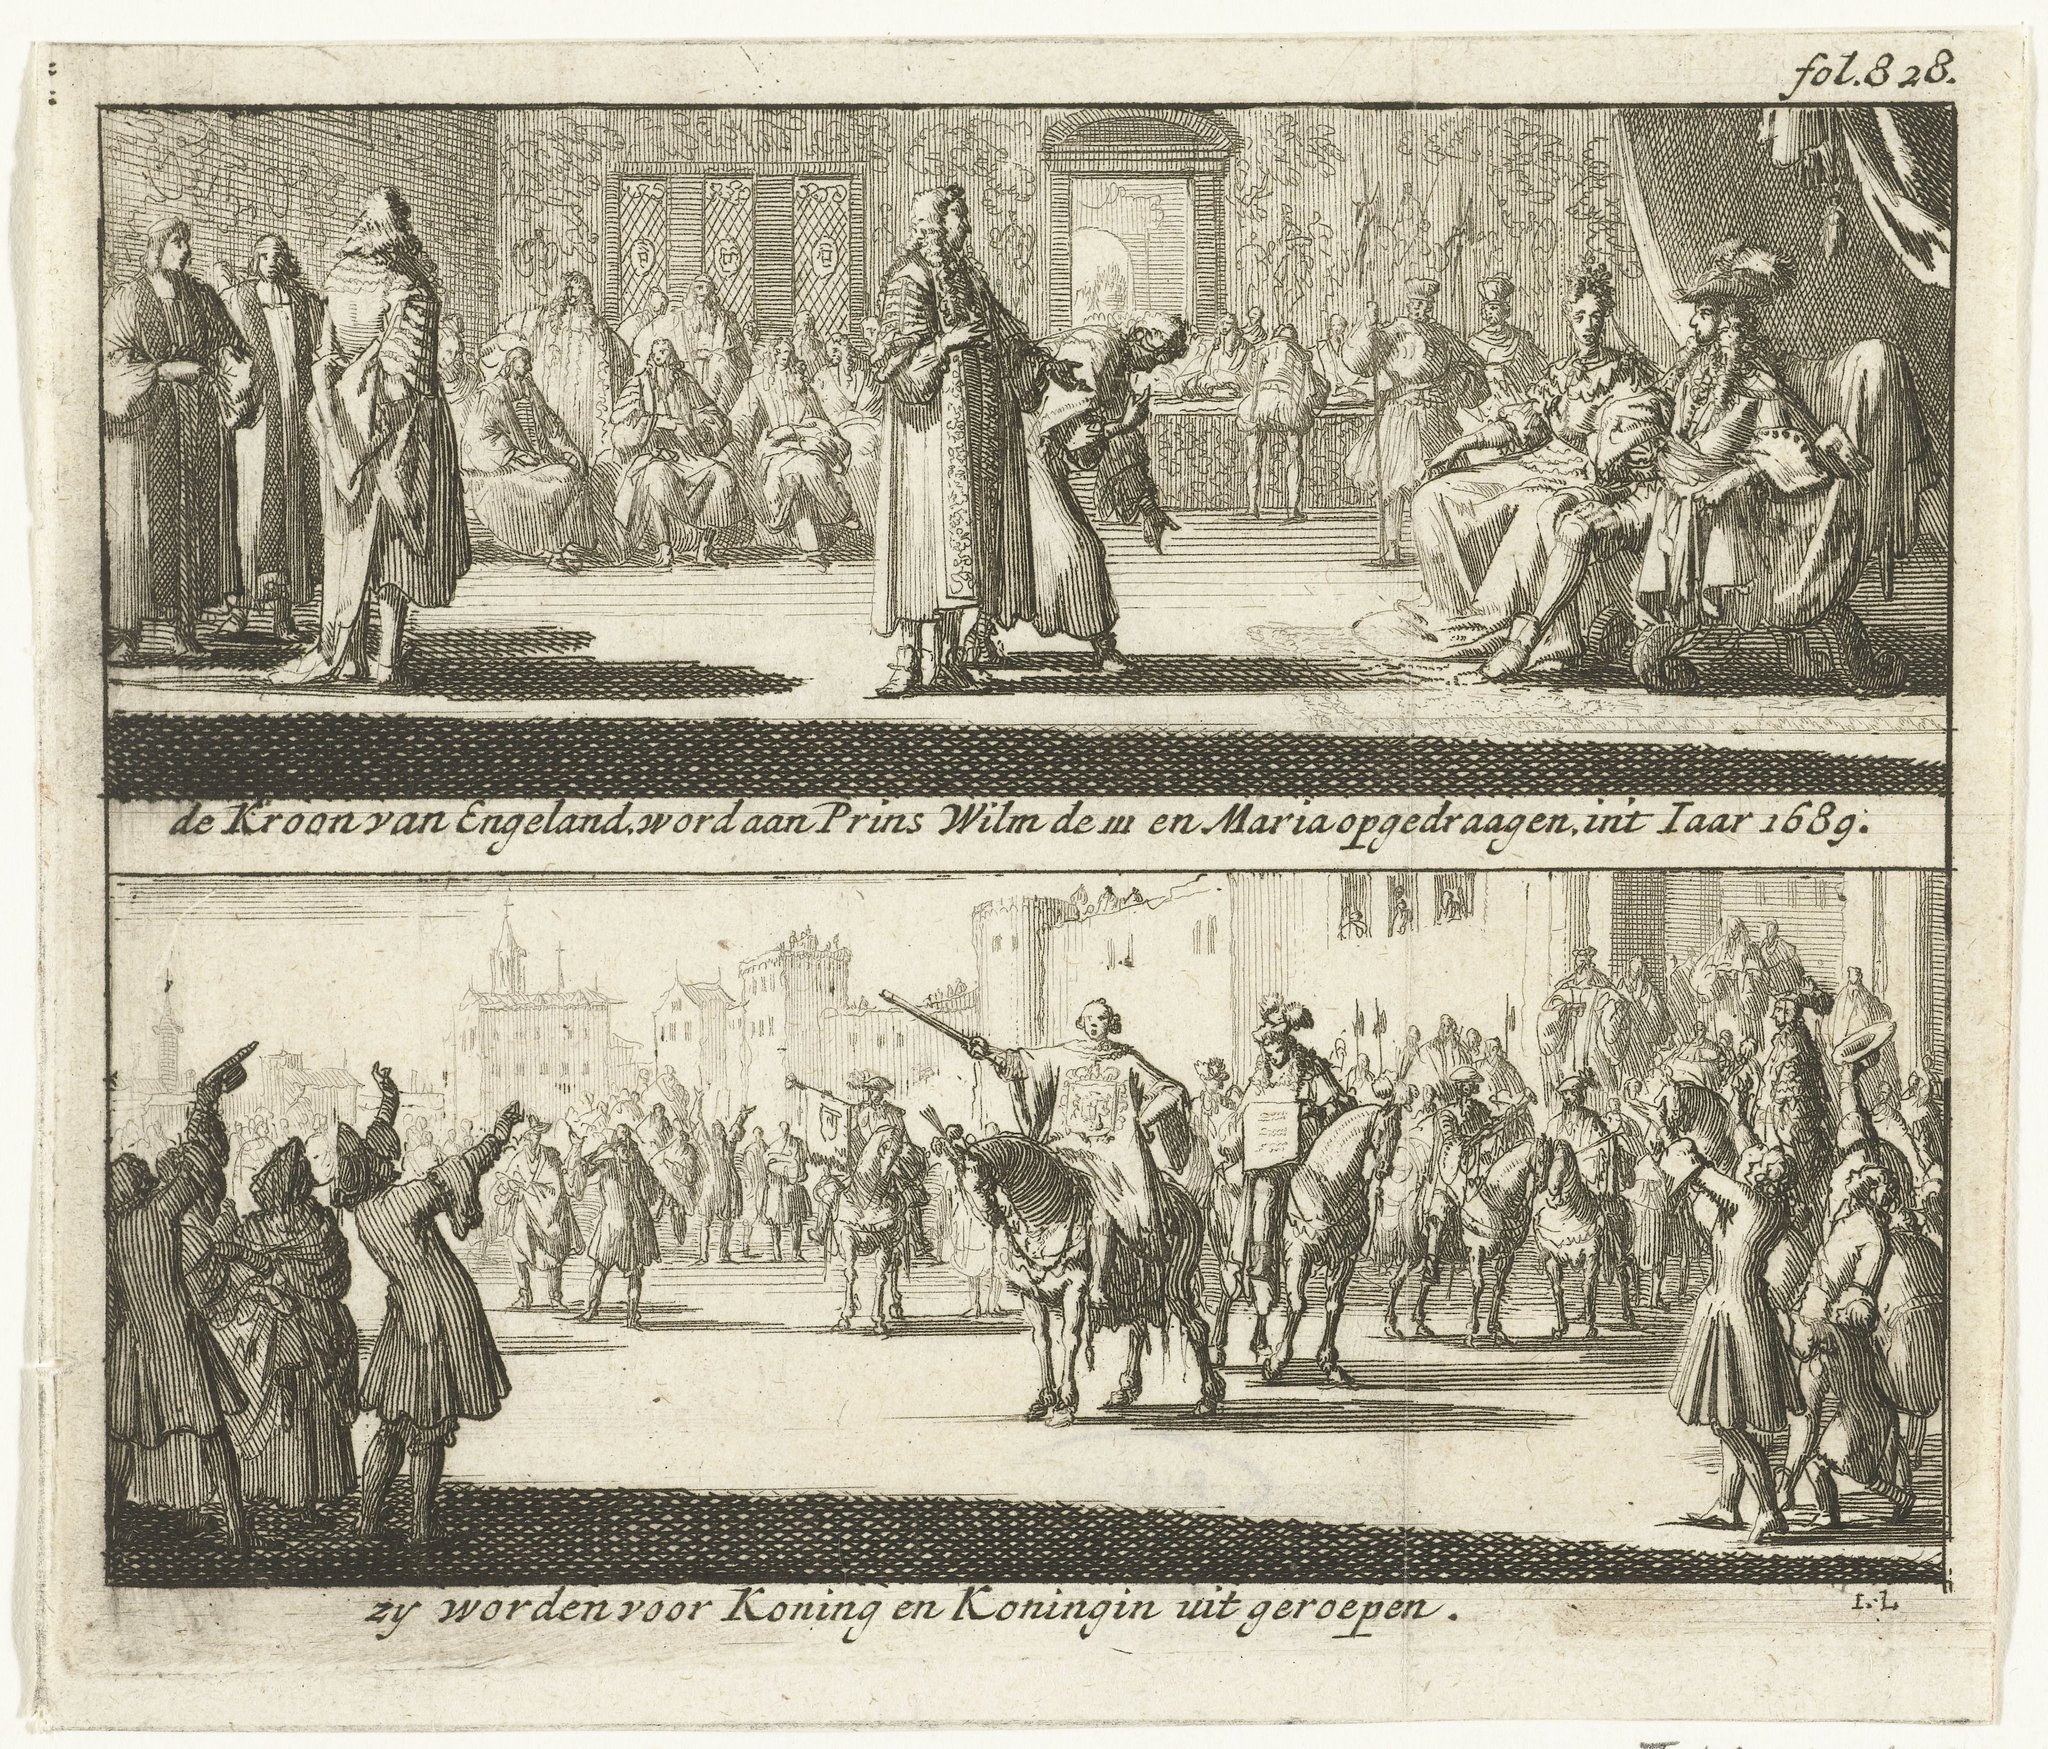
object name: print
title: Willem en Maria uitgeroepen tot koning en koningin van Engeland, 1689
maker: jan luyken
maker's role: draughtsman, print maker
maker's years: 1649-1712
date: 1689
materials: paper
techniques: etching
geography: northern netherlands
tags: the hague, william iii (prince of orange and king of england, scotland, and ireland), london, maria ii stuart (koningin van engeland, schotland en ierland), crier (~ proclamation of laws), oral spreading of news, town crier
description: Blad met twee voorstellingen. Boven wordt de Engelse kroon aangeboden aan Willem III en Maria, 23 februari 1689. Onder de bekendmaking op straat aan het volk door een stadsomroeper dat prins Willem III en prinses Maria Stuart tot koning en koningin van Engeland zijn uitgeroepen, 23 februari 1689. Gemerkt rechtsboven: fol. 828.